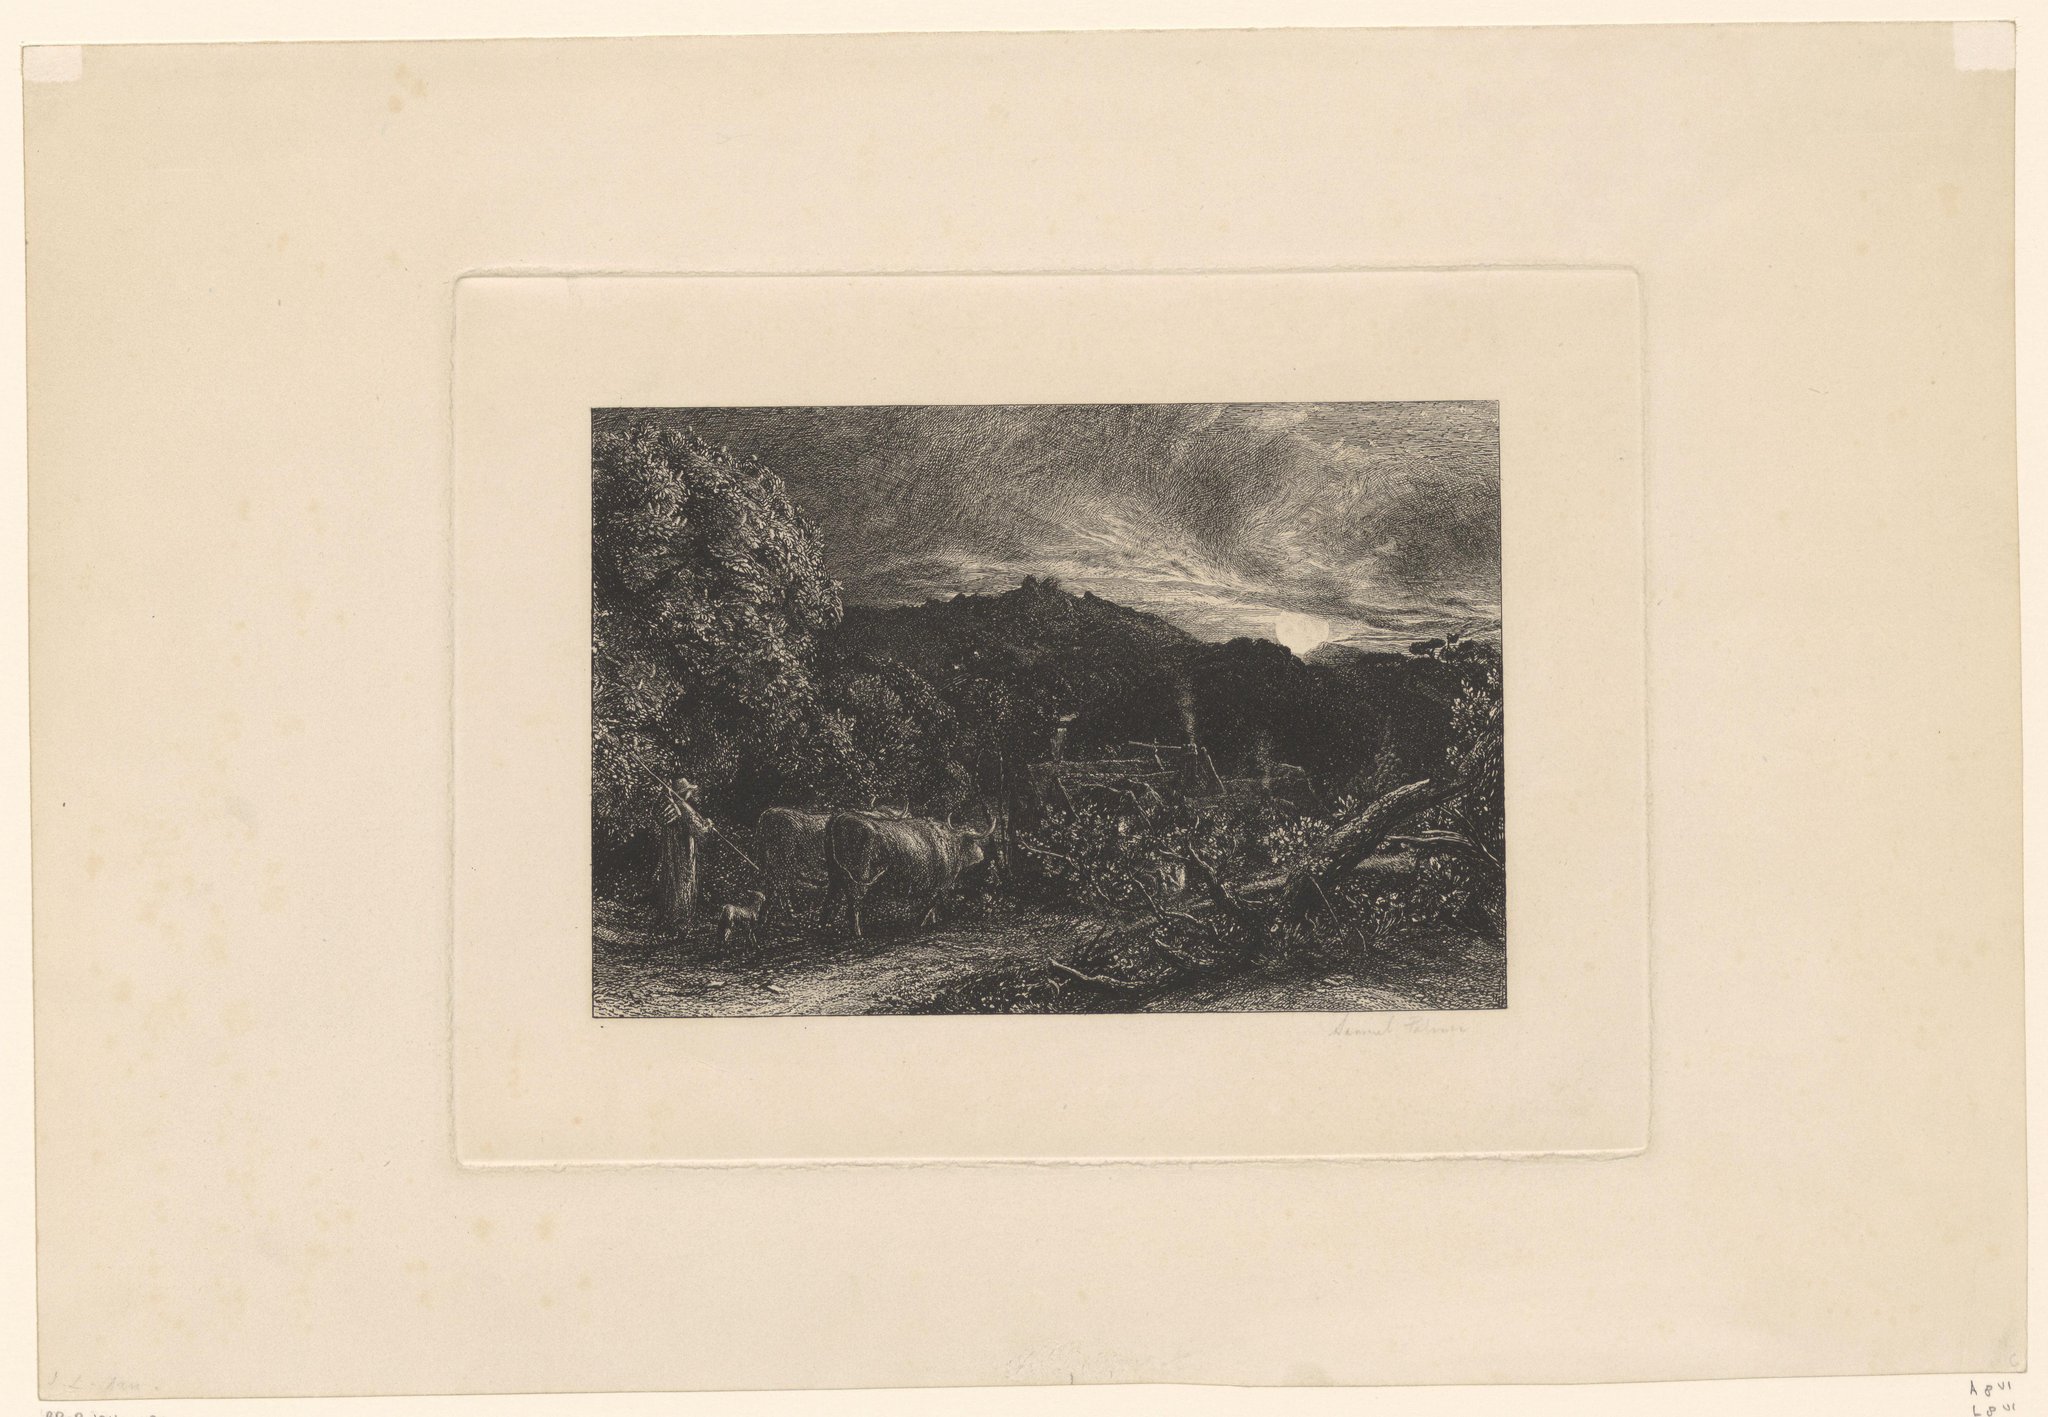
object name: print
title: Ploeger leidt zijn twee ossen richting huis bij maanlicht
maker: samuel palmer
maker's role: draughtsman, painter, print maker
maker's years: 1805-1881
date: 1858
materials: paper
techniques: etching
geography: england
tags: low hill country, moonlight, cottage, ox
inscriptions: collector's mark: Lugt 2228